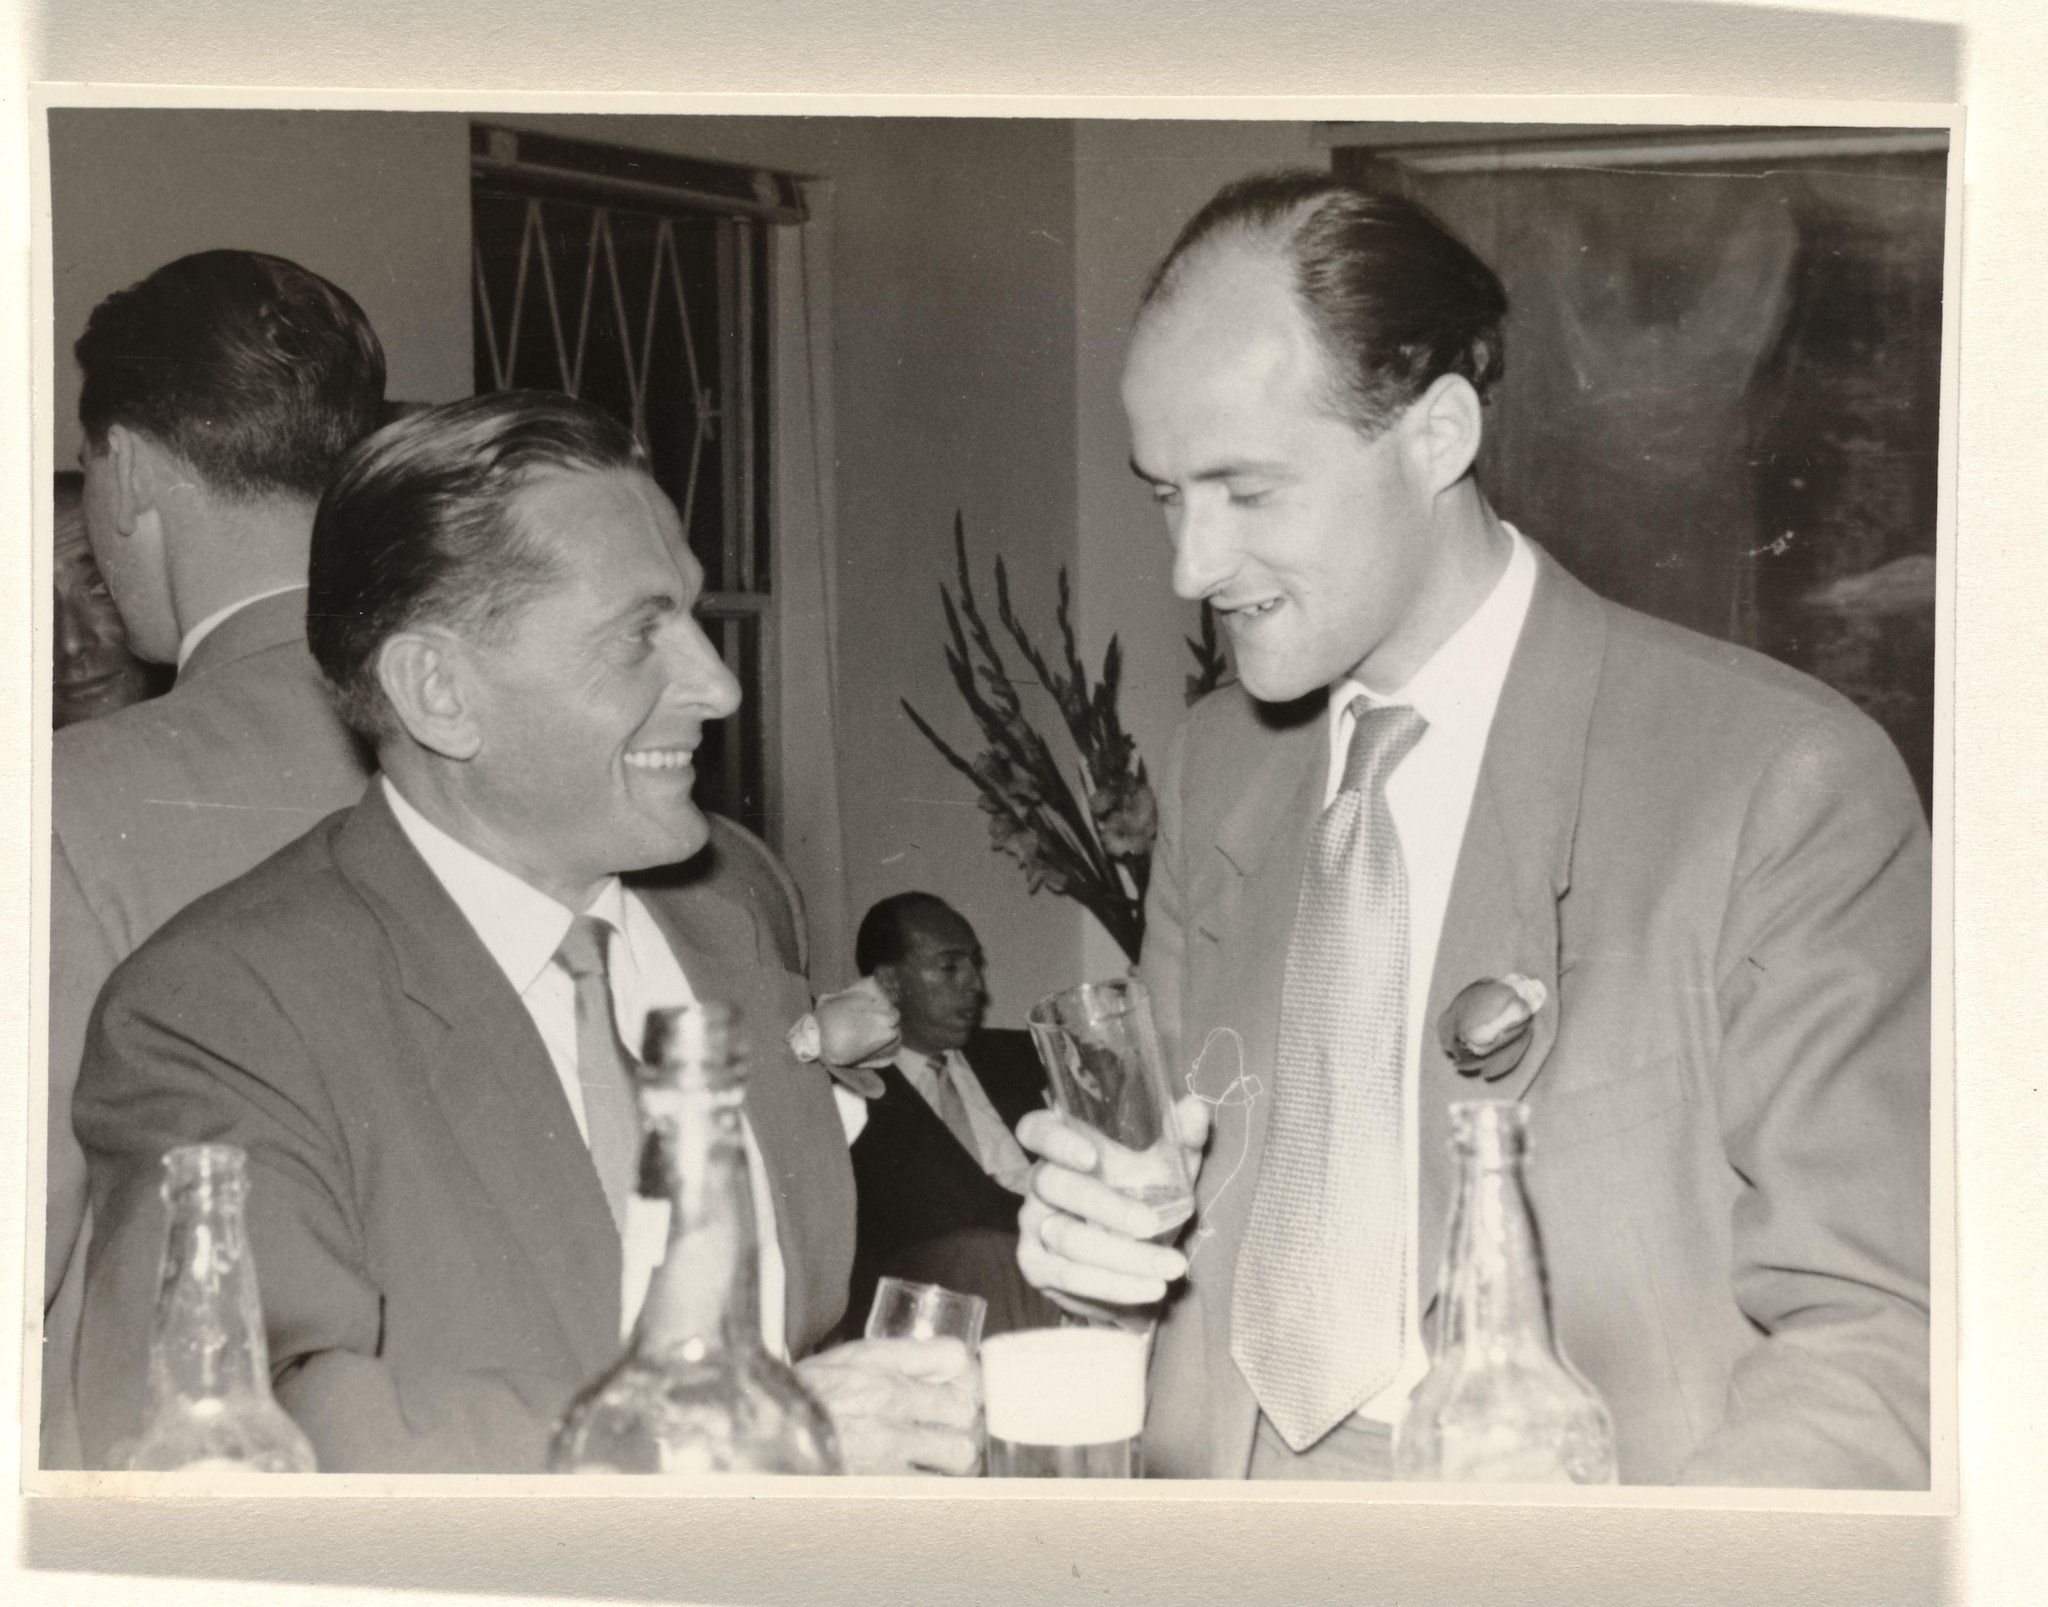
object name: photograph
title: Gideon Elon met een roos in zijn revers lachend in gesprek met een onbekende man, tijdens een receptie gedurende de KLM-tijd van Isabel Wachenheimer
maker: Anonymous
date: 1956-1973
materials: photographic support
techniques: gelatin silver print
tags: gideon elon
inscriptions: number: ‘2129/4’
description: Gideon Elon met een roos in zijn revers lachend in gesprek met een onbekende man, tijdens een receptie.